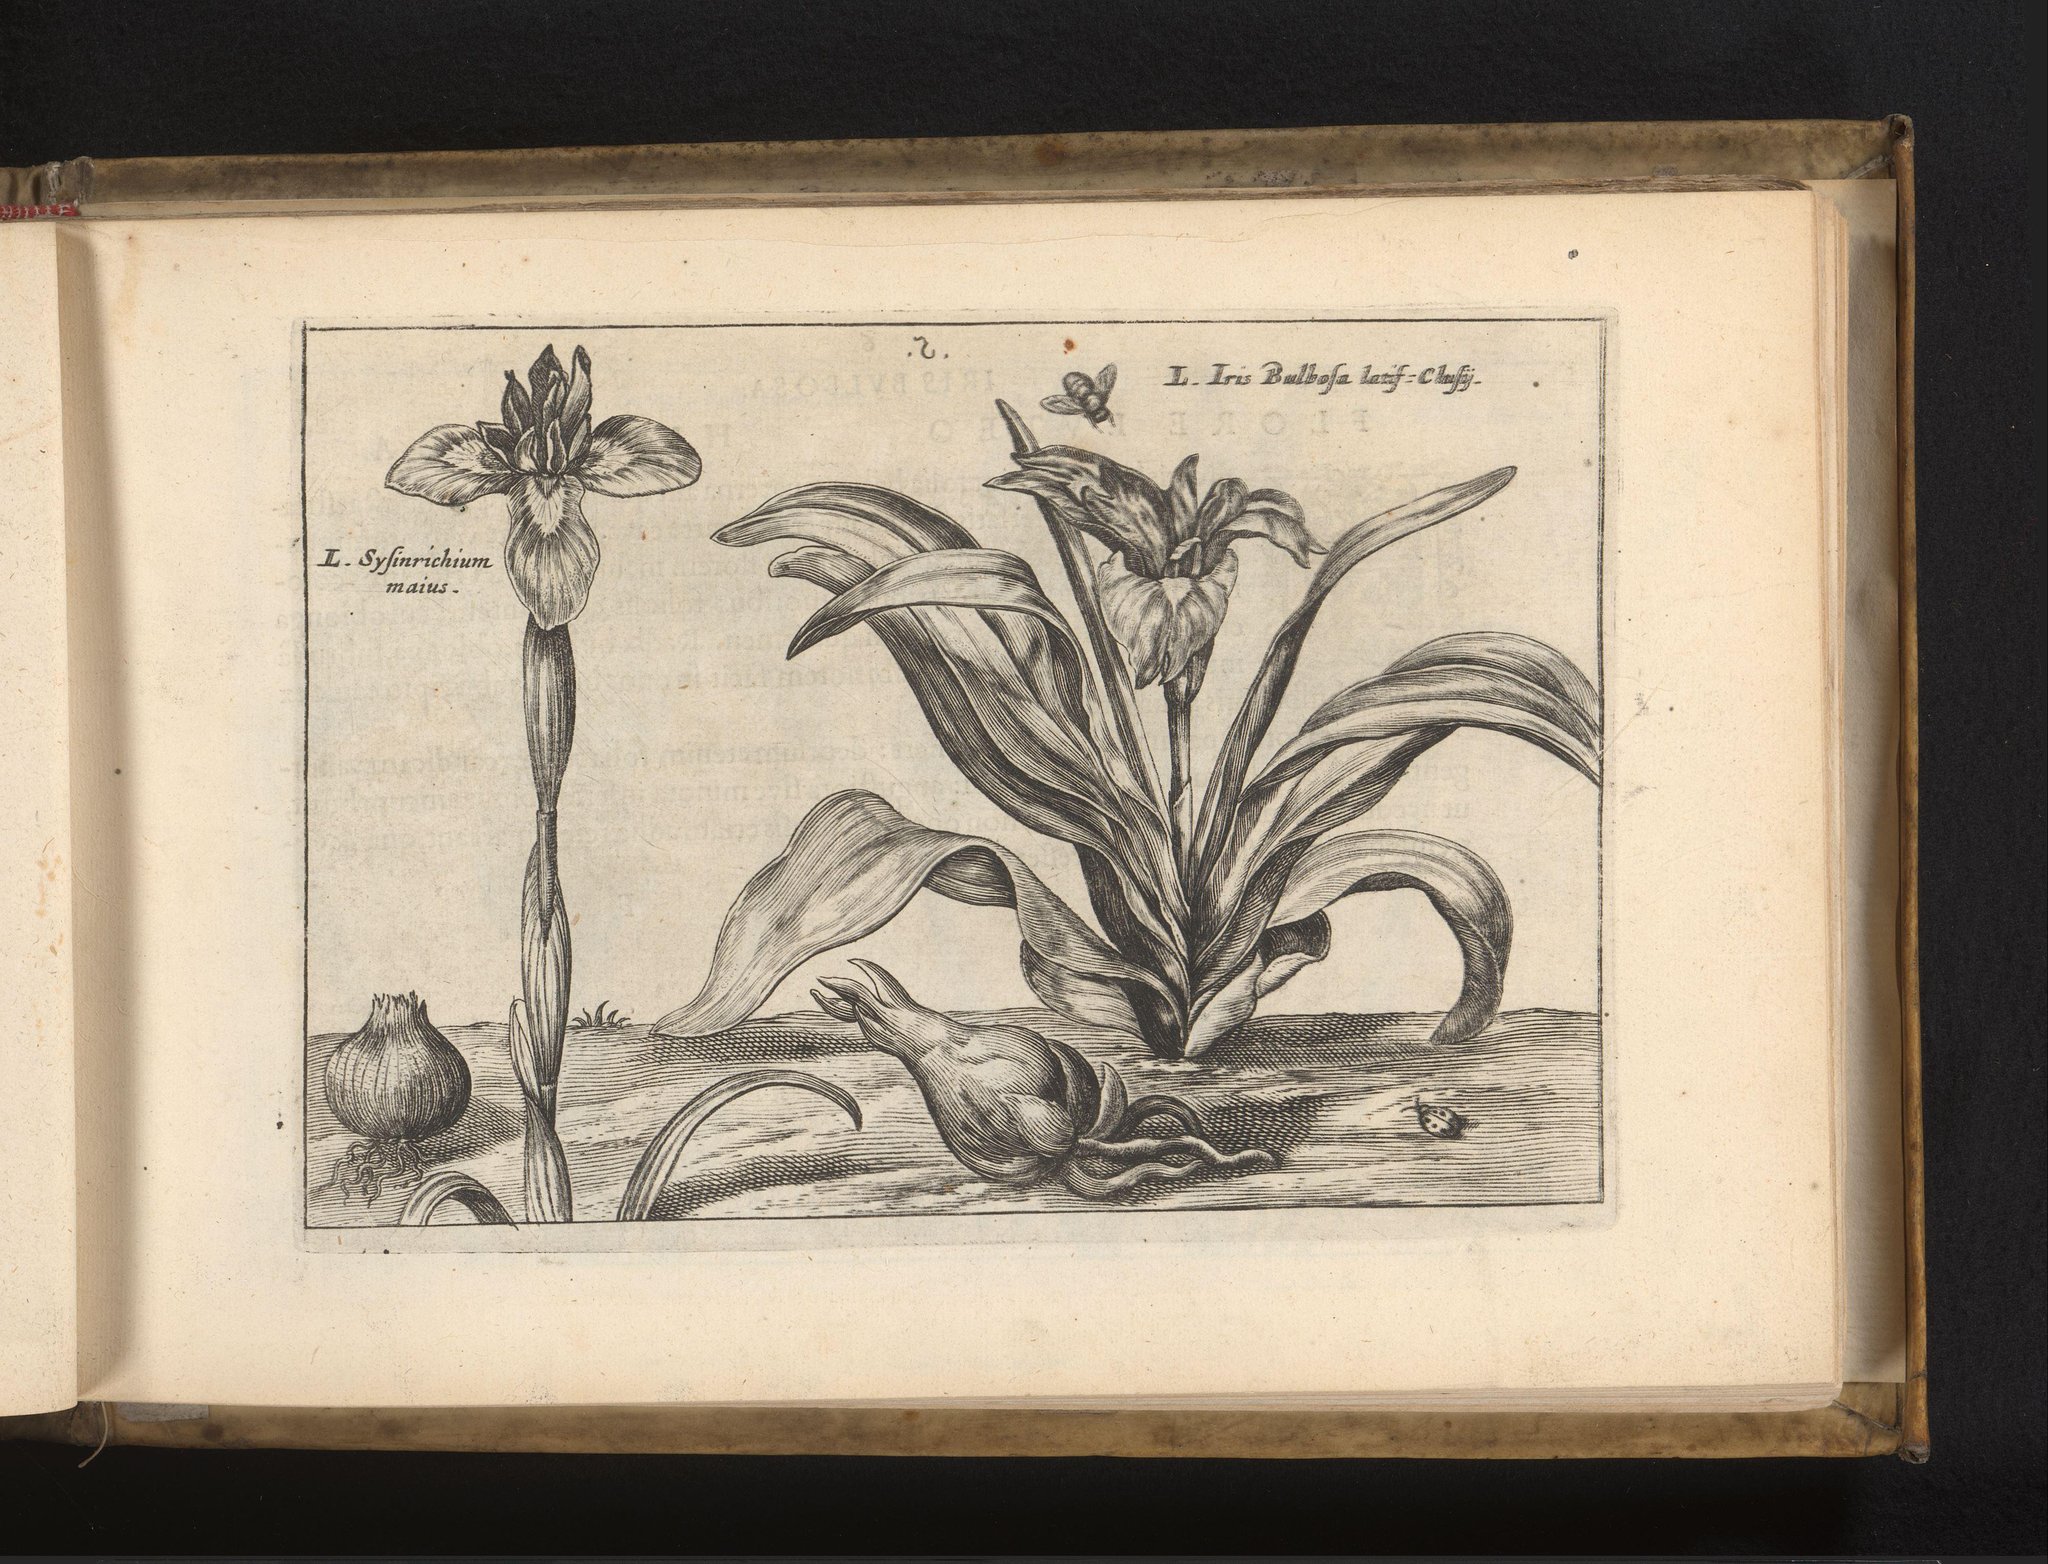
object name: print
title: Iris bulbosa latif. Clusii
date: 1617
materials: paper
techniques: engraving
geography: arnhem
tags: flowers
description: Prent uit: Passe, Crispijn van de (II). Hortus floridus in quo rariorum & minus vulgarium florum icones ad vivam veramque formam. Arnhem: Johannes Janssonius, 1617.